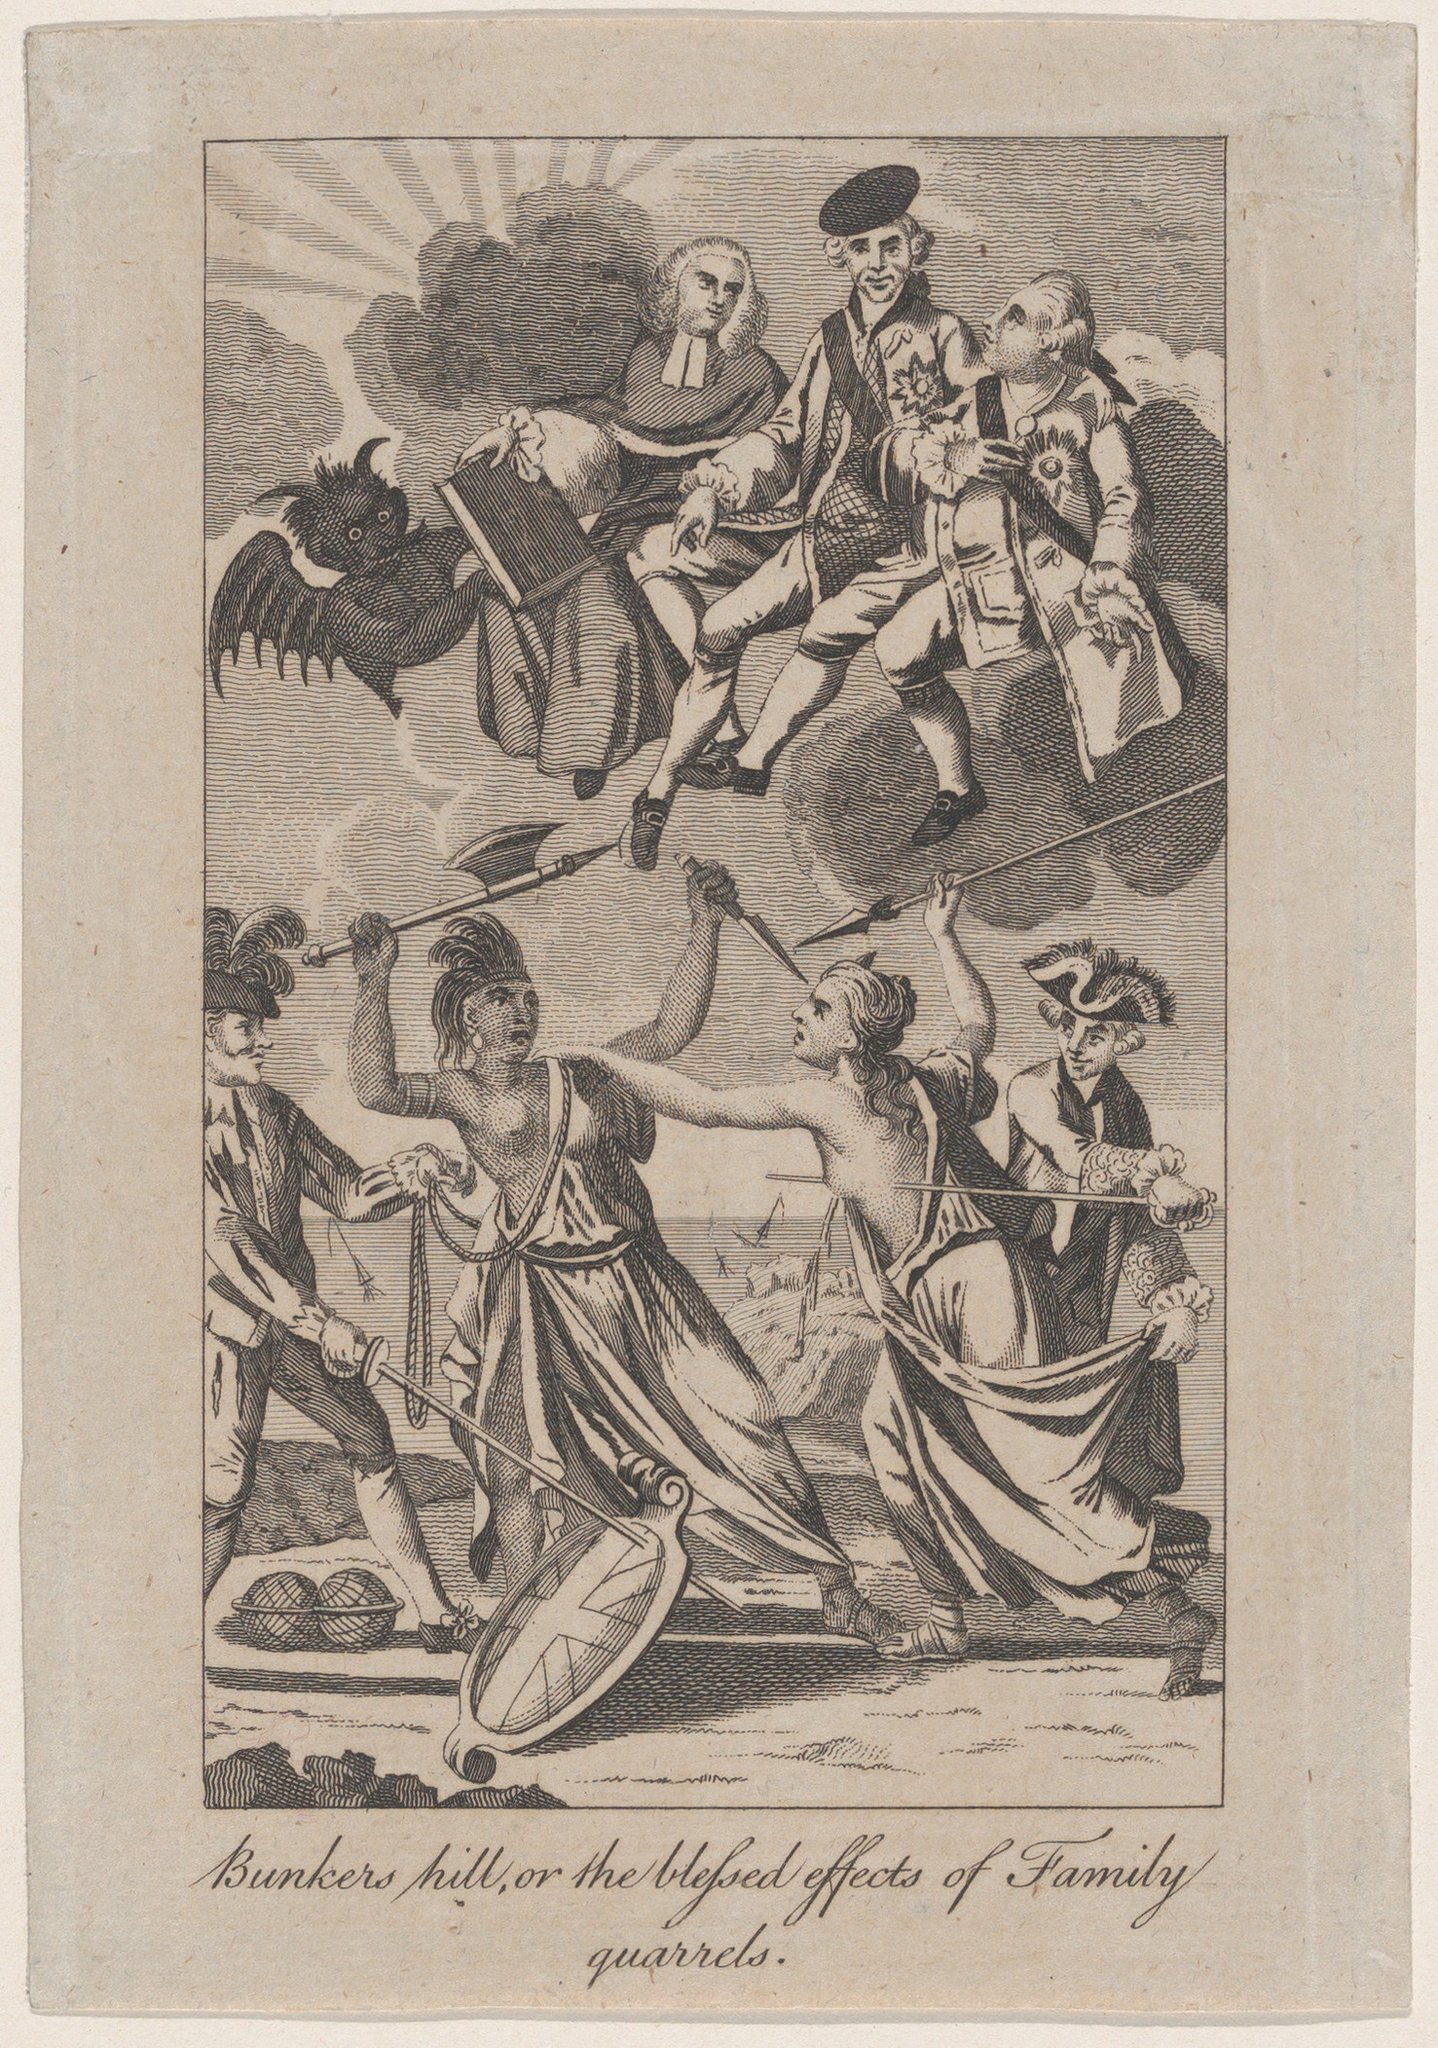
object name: print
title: Bunkers Hill, or the Blessed Effects of Family Quarrels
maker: anonymous, british, 18th century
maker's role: artist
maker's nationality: british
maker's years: 1700-1800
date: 1775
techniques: engraving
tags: satire,american revolution,men,women,demons,politics